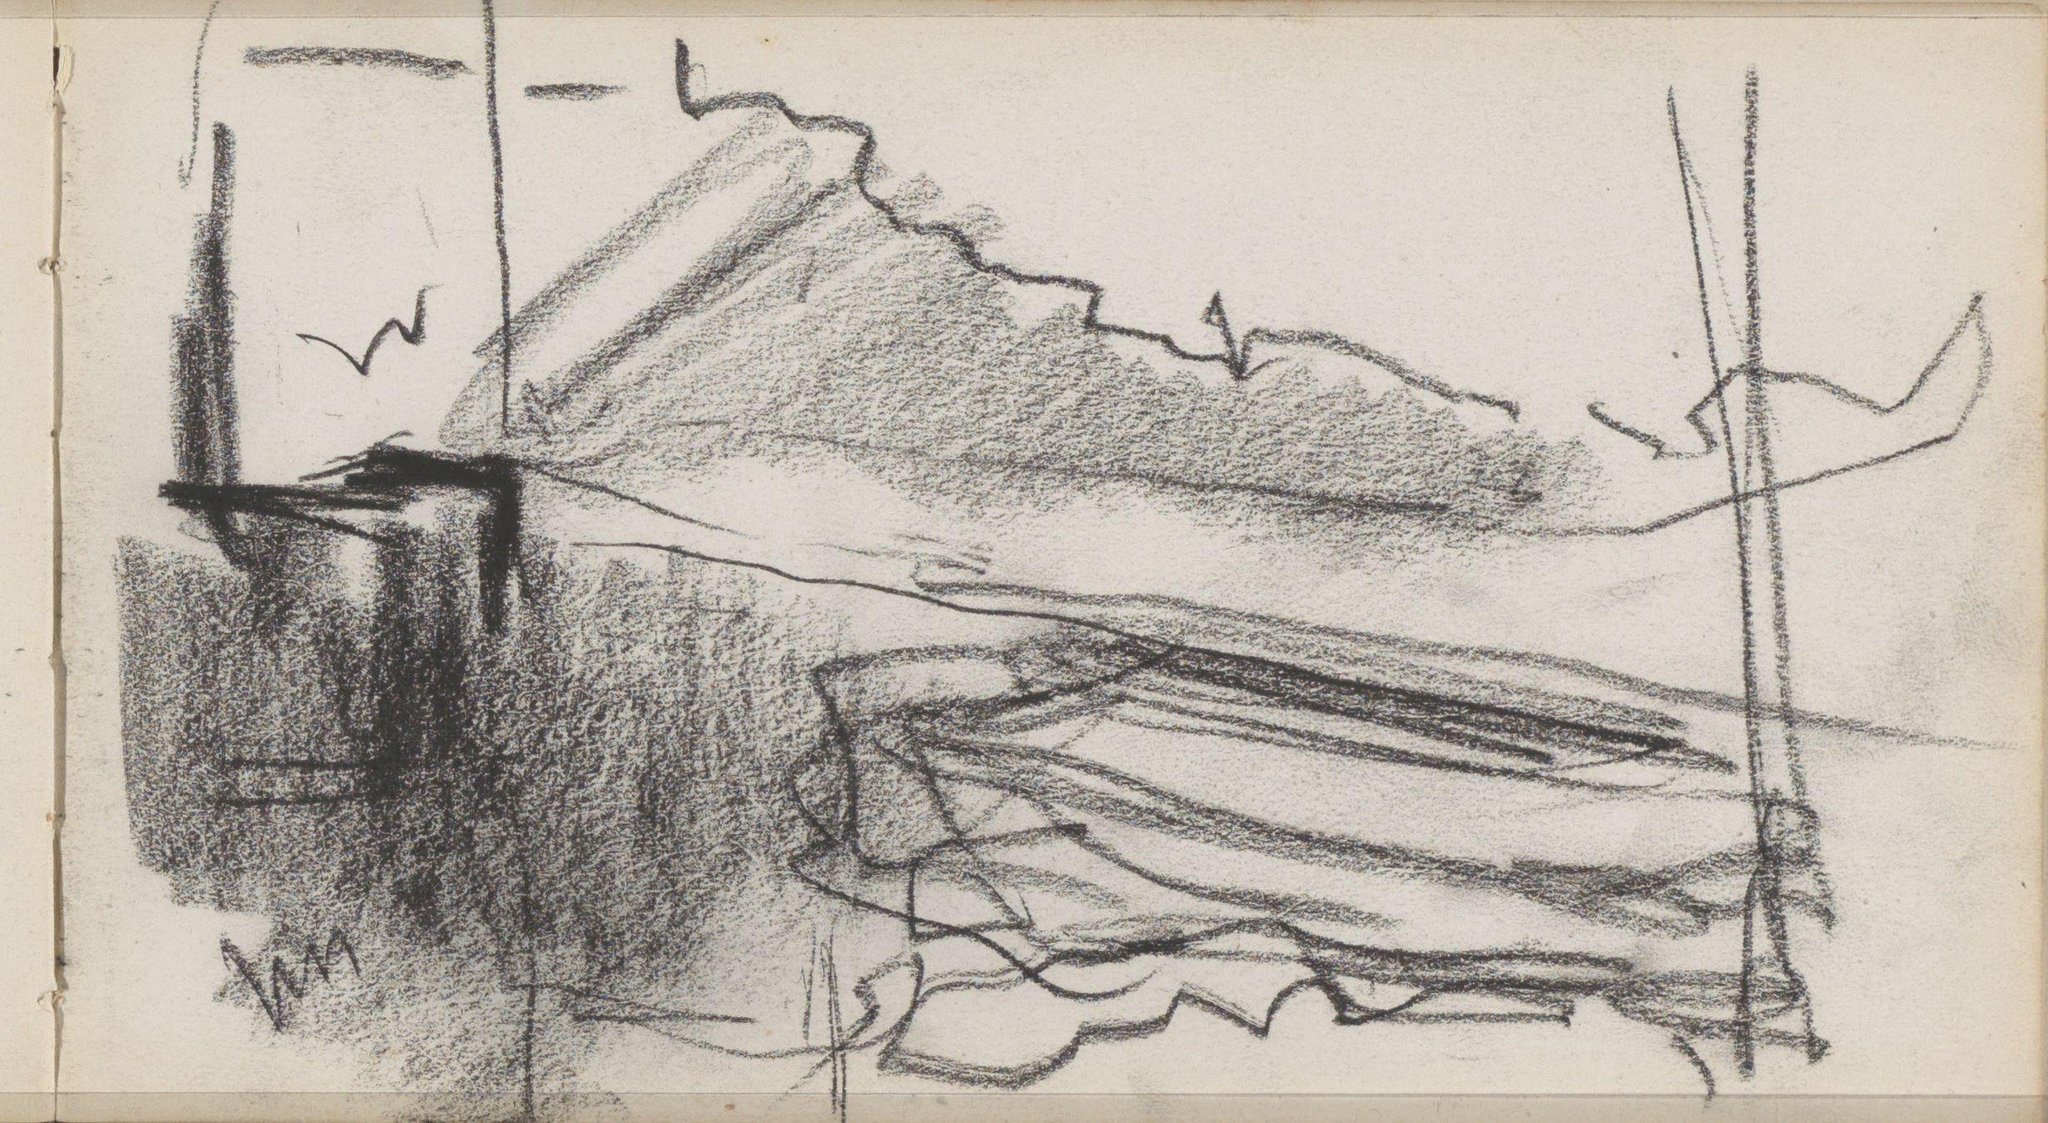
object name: sketchbook leaf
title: Studie, mogelijk van gebouwen aan het water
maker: george hendrik breitner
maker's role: draughtsman, painter, print maker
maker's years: 1857-1923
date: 1886-1923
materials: chalk, paper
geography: amsterdam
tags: canals, waters (in city), civic architecture; edifices; dwellings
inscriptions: kleurnotitie, handgeschreven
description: Pagina 10 uit een schetsboek met 39 bladen.